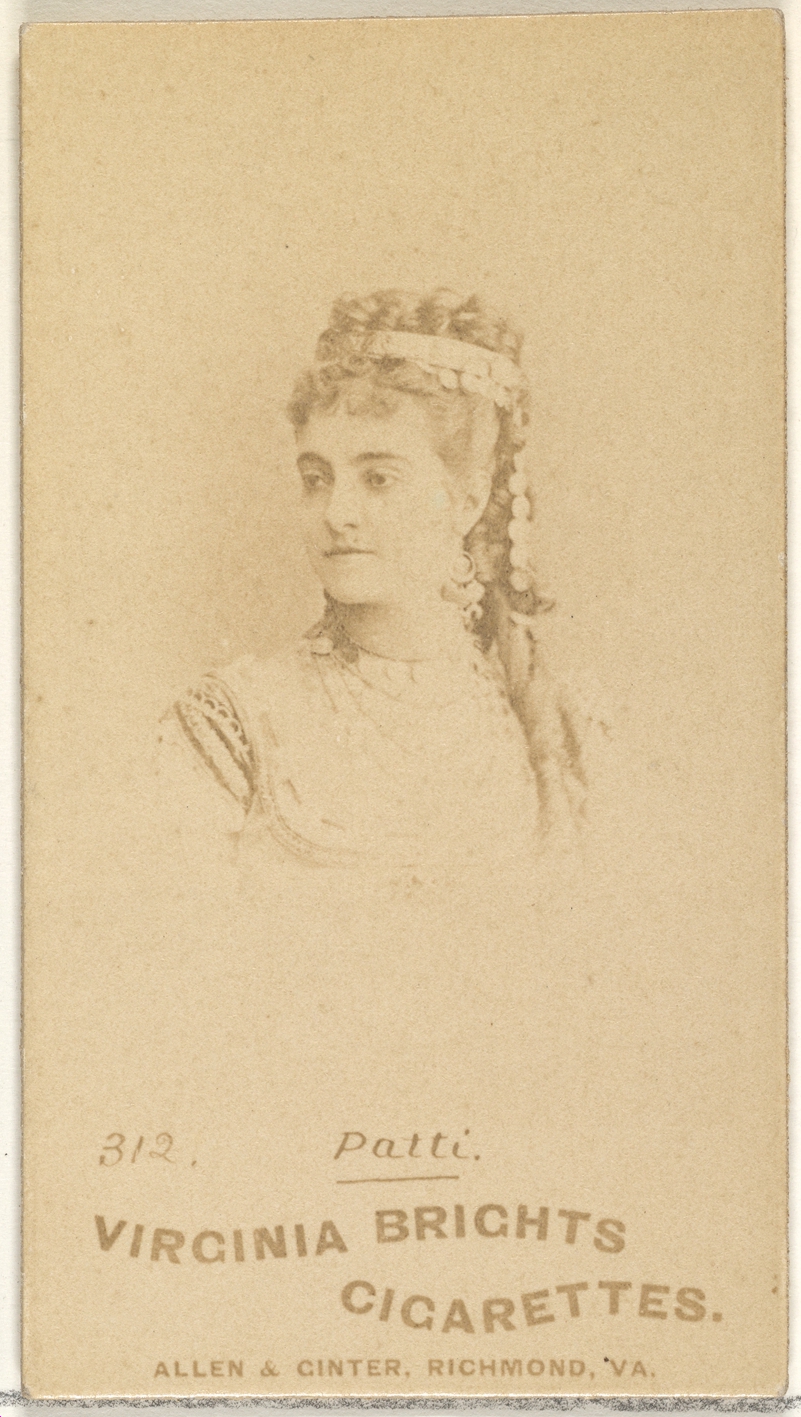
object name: photograph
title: Card 312, Patti, from the Actors and Actresses series (N45, Type 1) for Virginia Brights Cigarettes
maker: allen & ginter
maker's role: publisher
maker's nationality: american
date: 1888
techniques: albumen silver print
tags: portraits,women,actresses